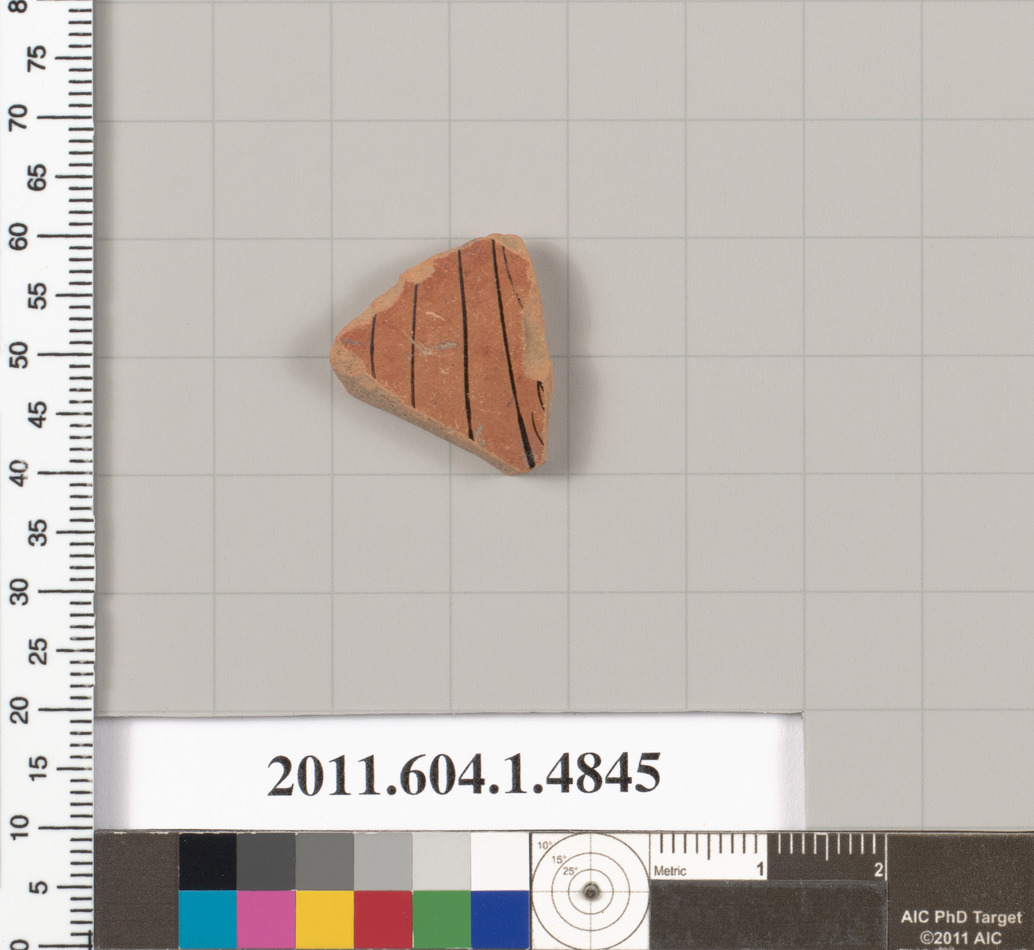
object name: kylix fragment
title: Terracotta fragment of a kylix (drinking cup)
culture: greek, attic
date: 475-451 BCE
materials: terracotta